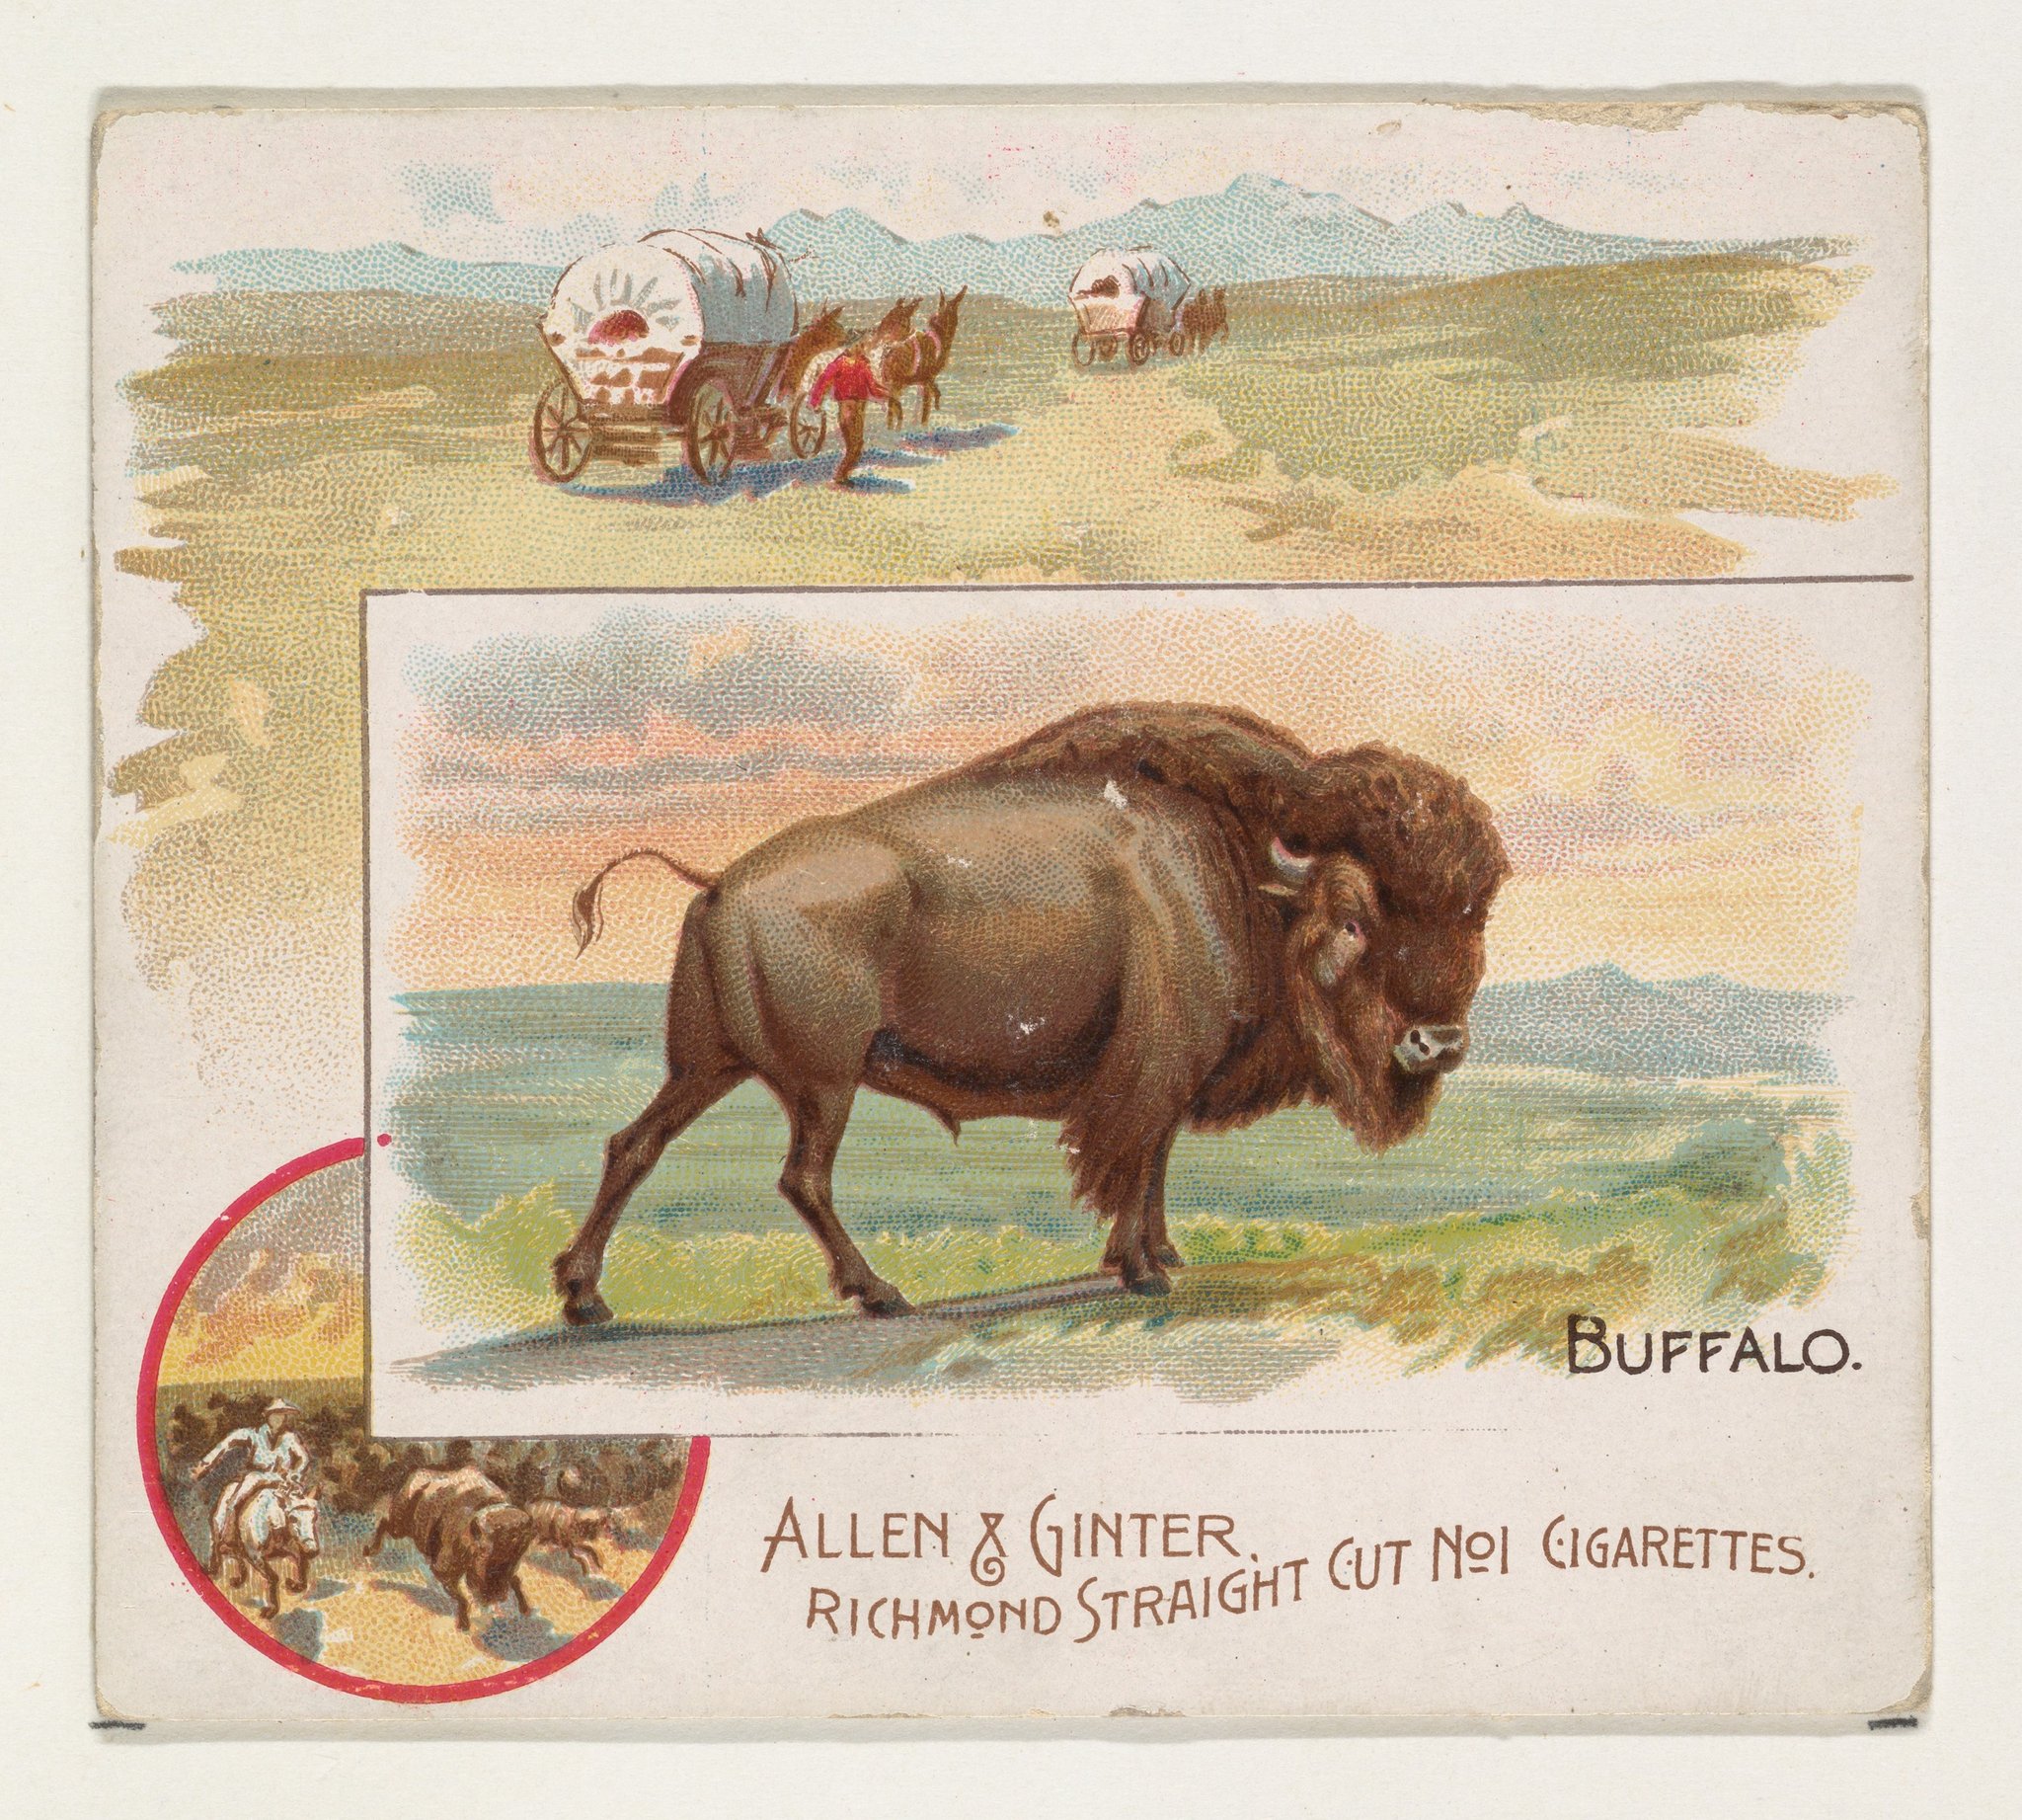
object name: print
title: Buffalo, from Quadrupeds series (N41) for Allen & Ginter Cigarettes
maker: allen & ginter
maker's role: publisher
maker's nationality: american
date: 1890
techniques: color lithograph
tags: buffalos